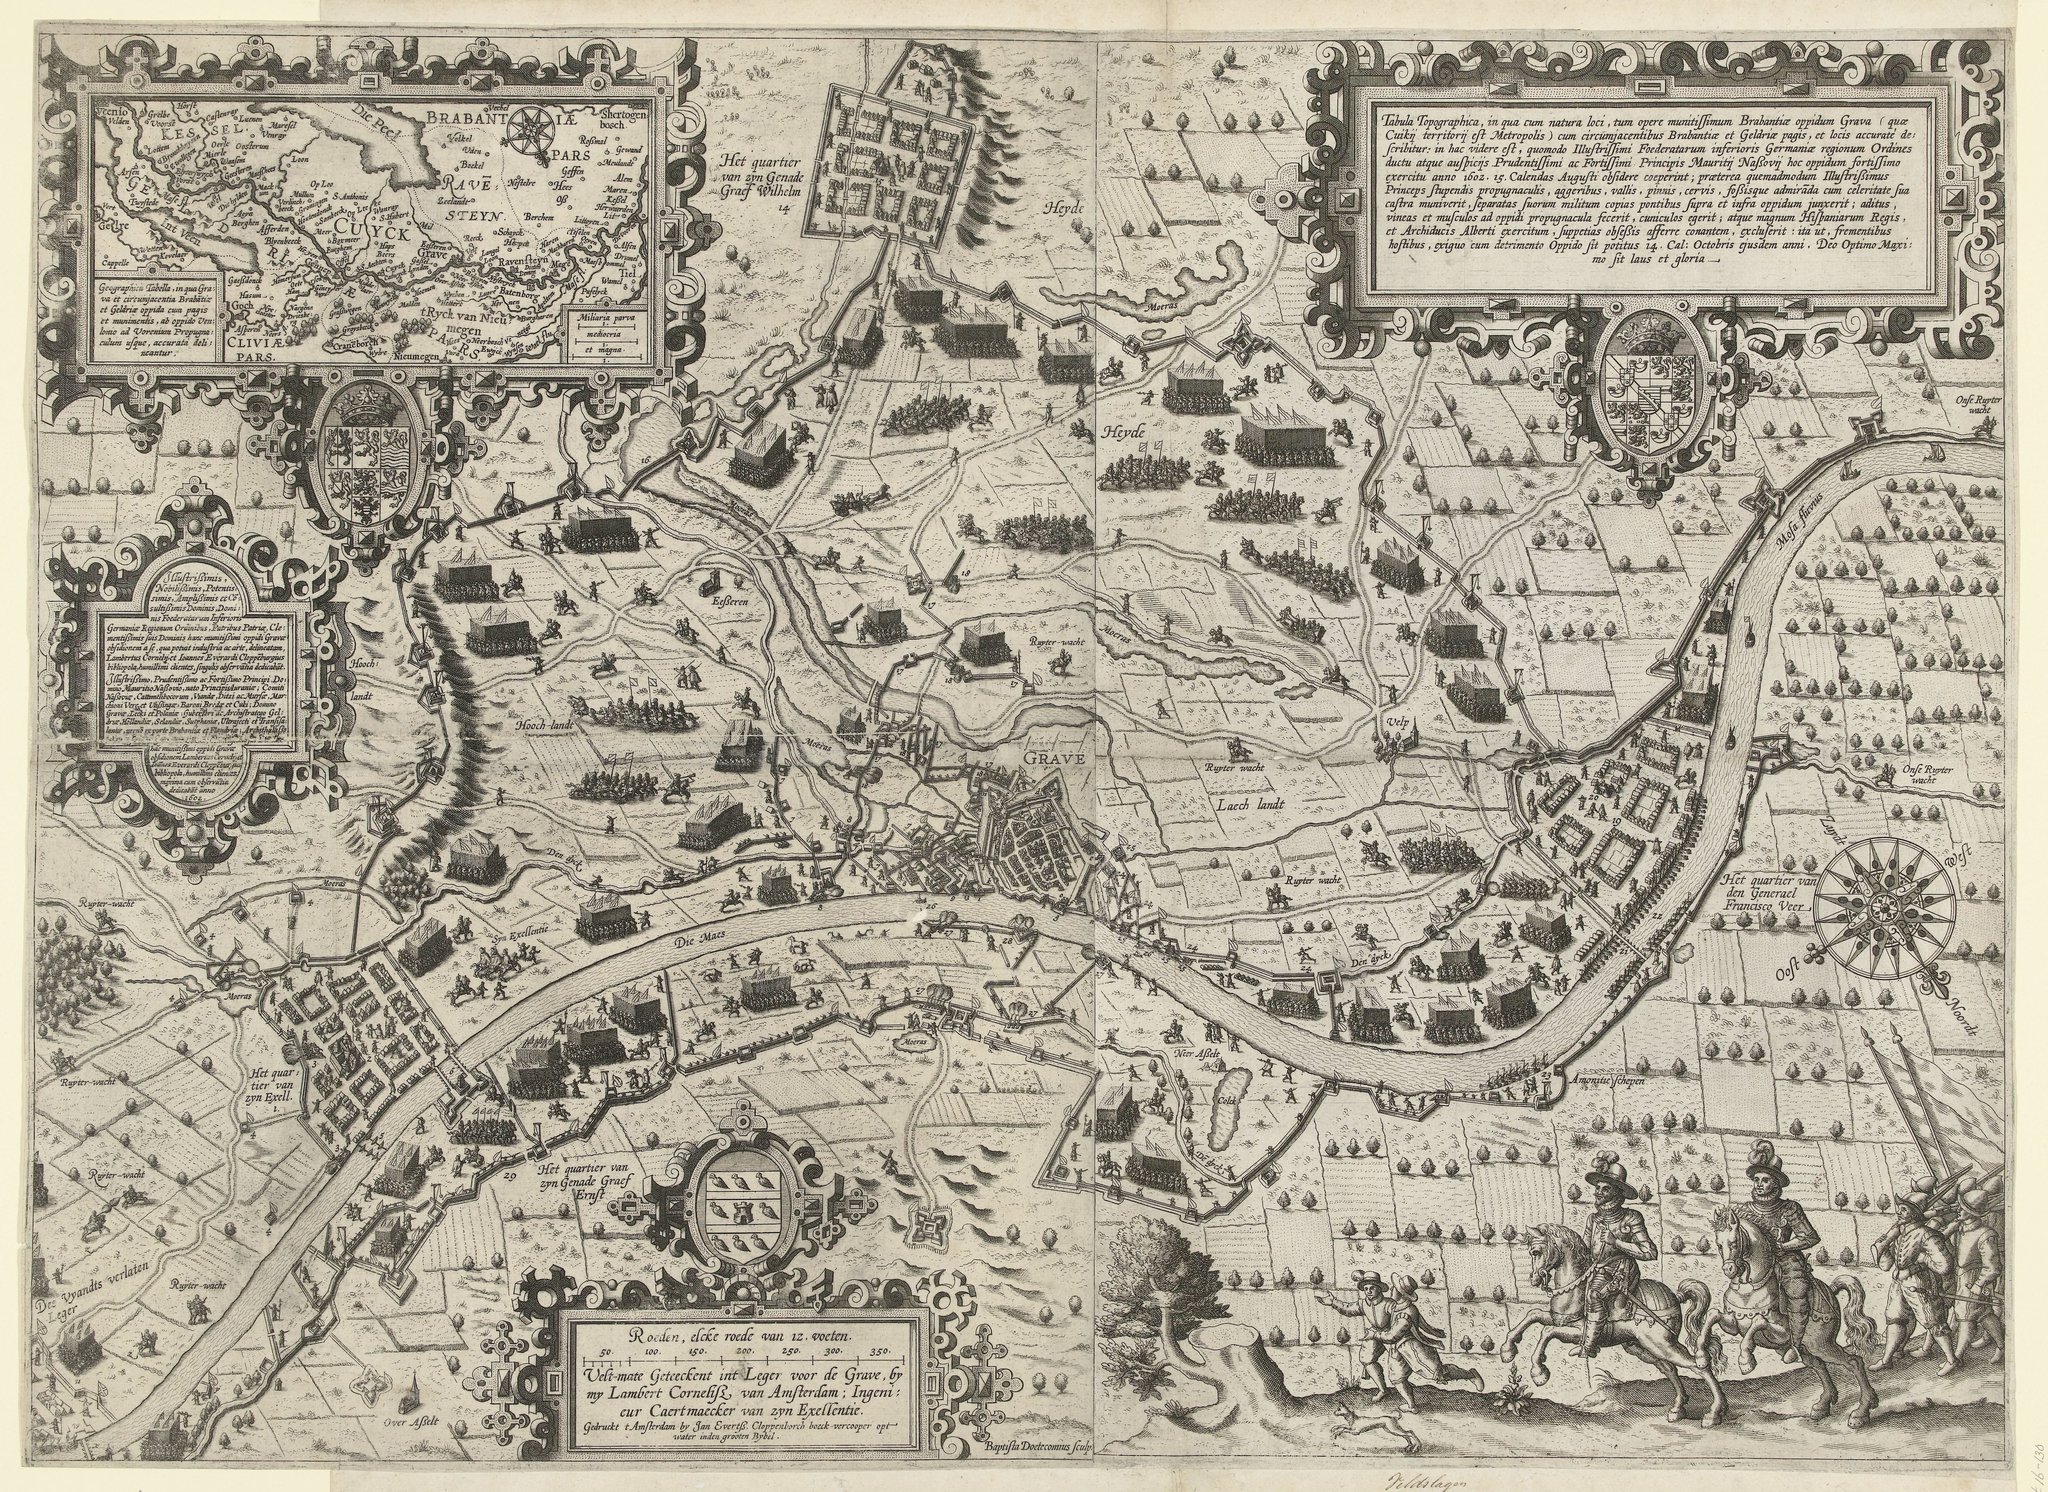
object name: print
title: Beleg van Grave, 1602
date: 1602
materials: paper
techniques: etching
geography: northern netherlands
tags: delft, the hague, frederick henry (prince of orange), maurice (prince of orange), maps of separate countries or regions, siege, position war, grave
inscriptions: date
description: Grote voorstelling op twee platen van het beleg en de inname van Grave door het Staatse leger onder Maurits, juli-september 1602. Grave en het omliggende land aan de Maas met het kwartier van de prins, Vere, graaf Willem en graaf Ernst Casimir. Linksboven een inzet met een kaartje van het land van Cuyck. Verder cartouches met opschriften, de opdracht en de schalen. Rechtsonder prins Maurits en Frederik Hendrik te paard. Op de achterzijde de legenda 1-29 en A-Z in het Nederlands.